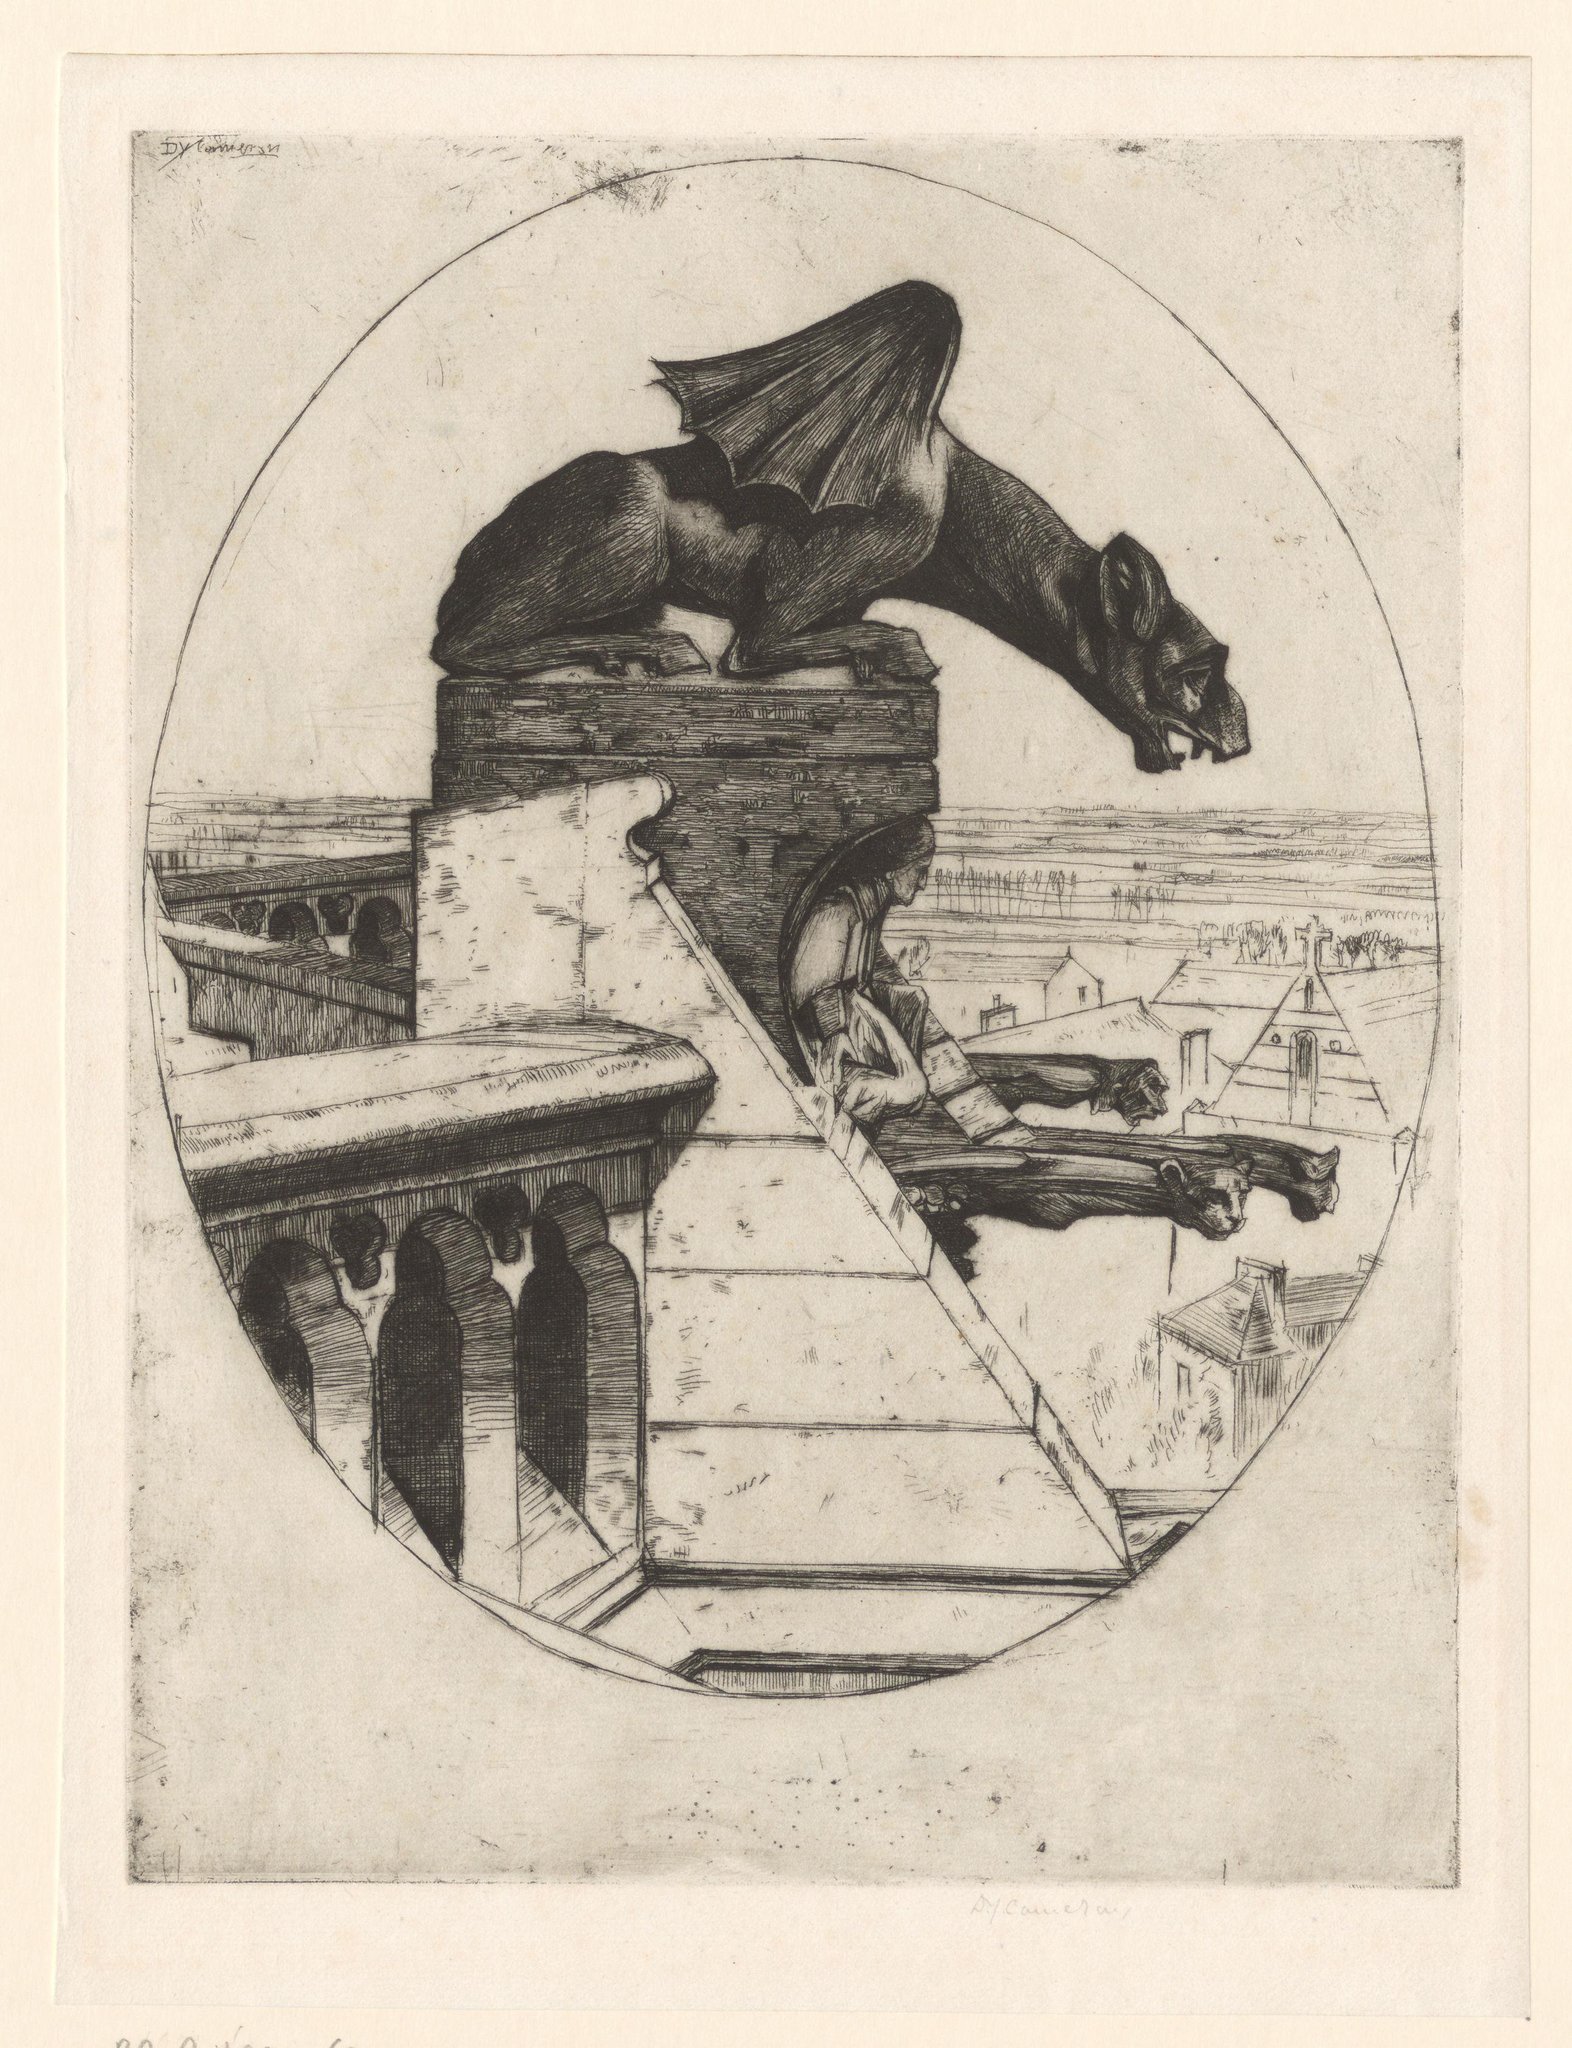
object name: print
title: Waterspuwers van de kathedraal van Amiens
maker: david young cameron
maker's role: draughtsman, print maker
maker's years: 1865-1945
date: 1910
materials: paper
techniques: drypoint, etching, intaglio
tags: church (exterior), chimera (lion/goat/snake); 'chimera' (ripa)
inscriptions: collector's mark: Lugt 2228, collector's mark: Lugt 2760